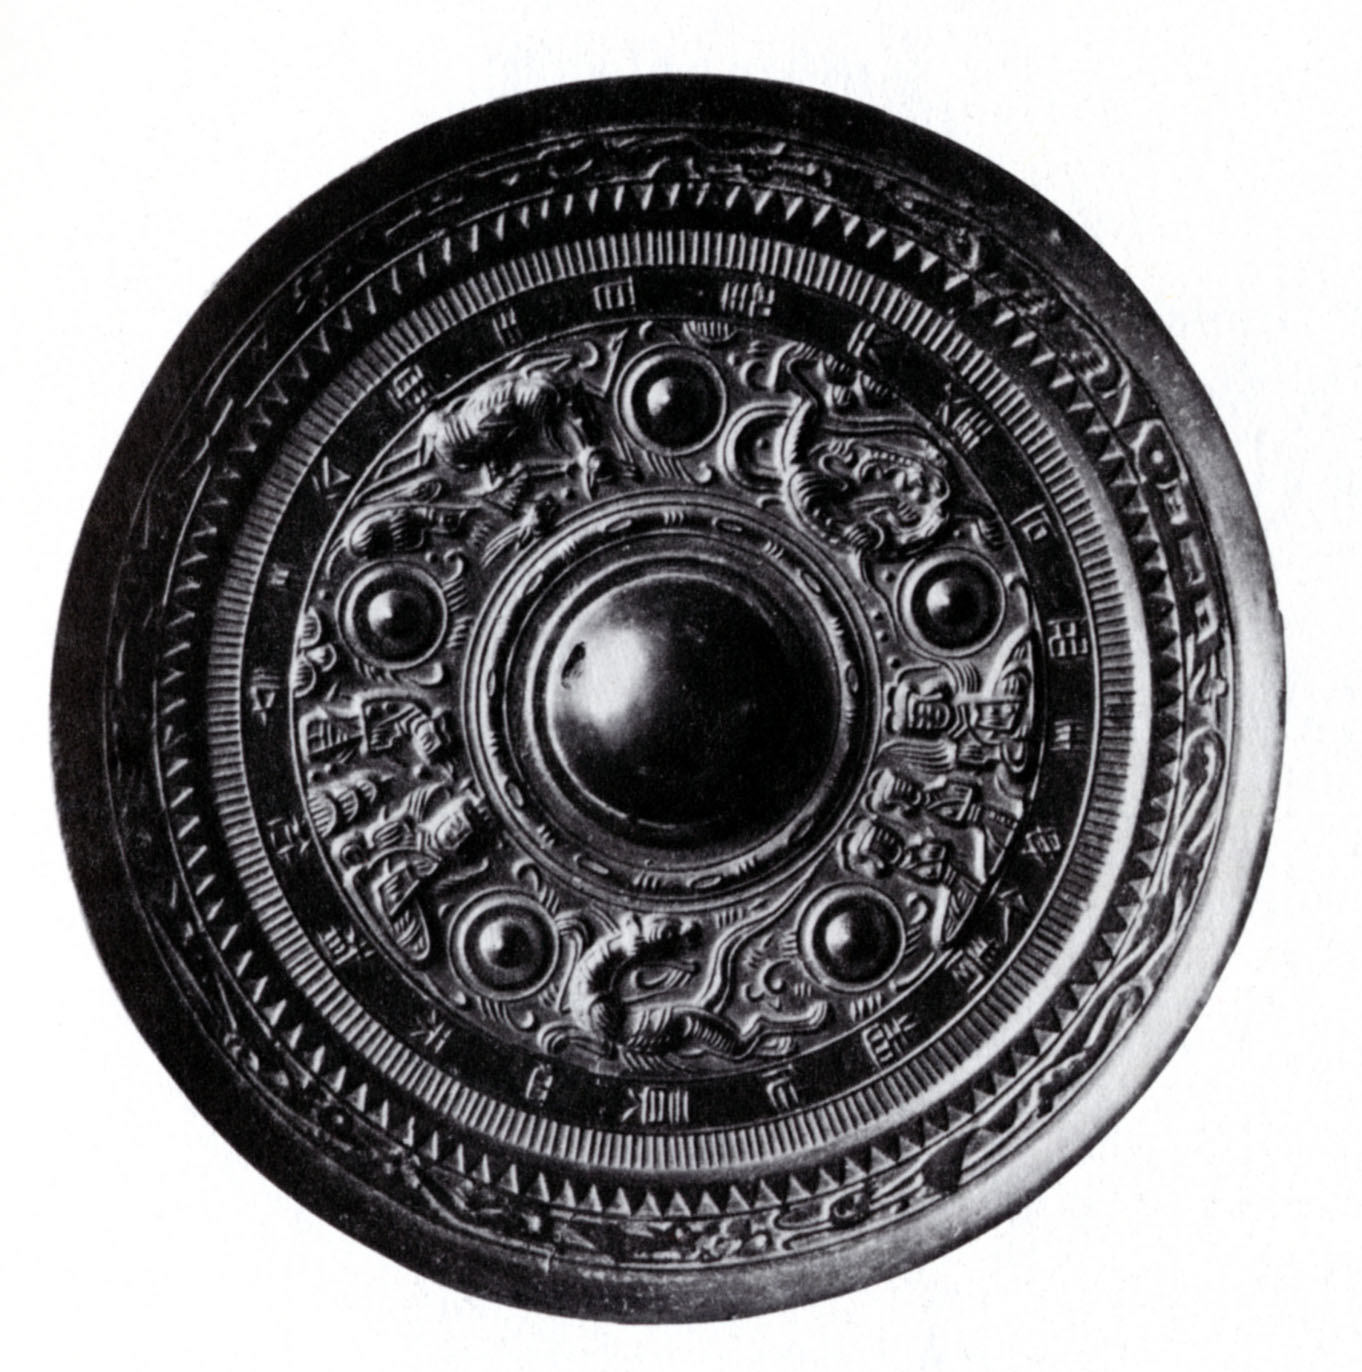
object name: mirror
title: Mirror with Queen Mother of the West, Lord of the East, and mythical creatures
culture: chinese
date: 101-300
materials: bronze, patina